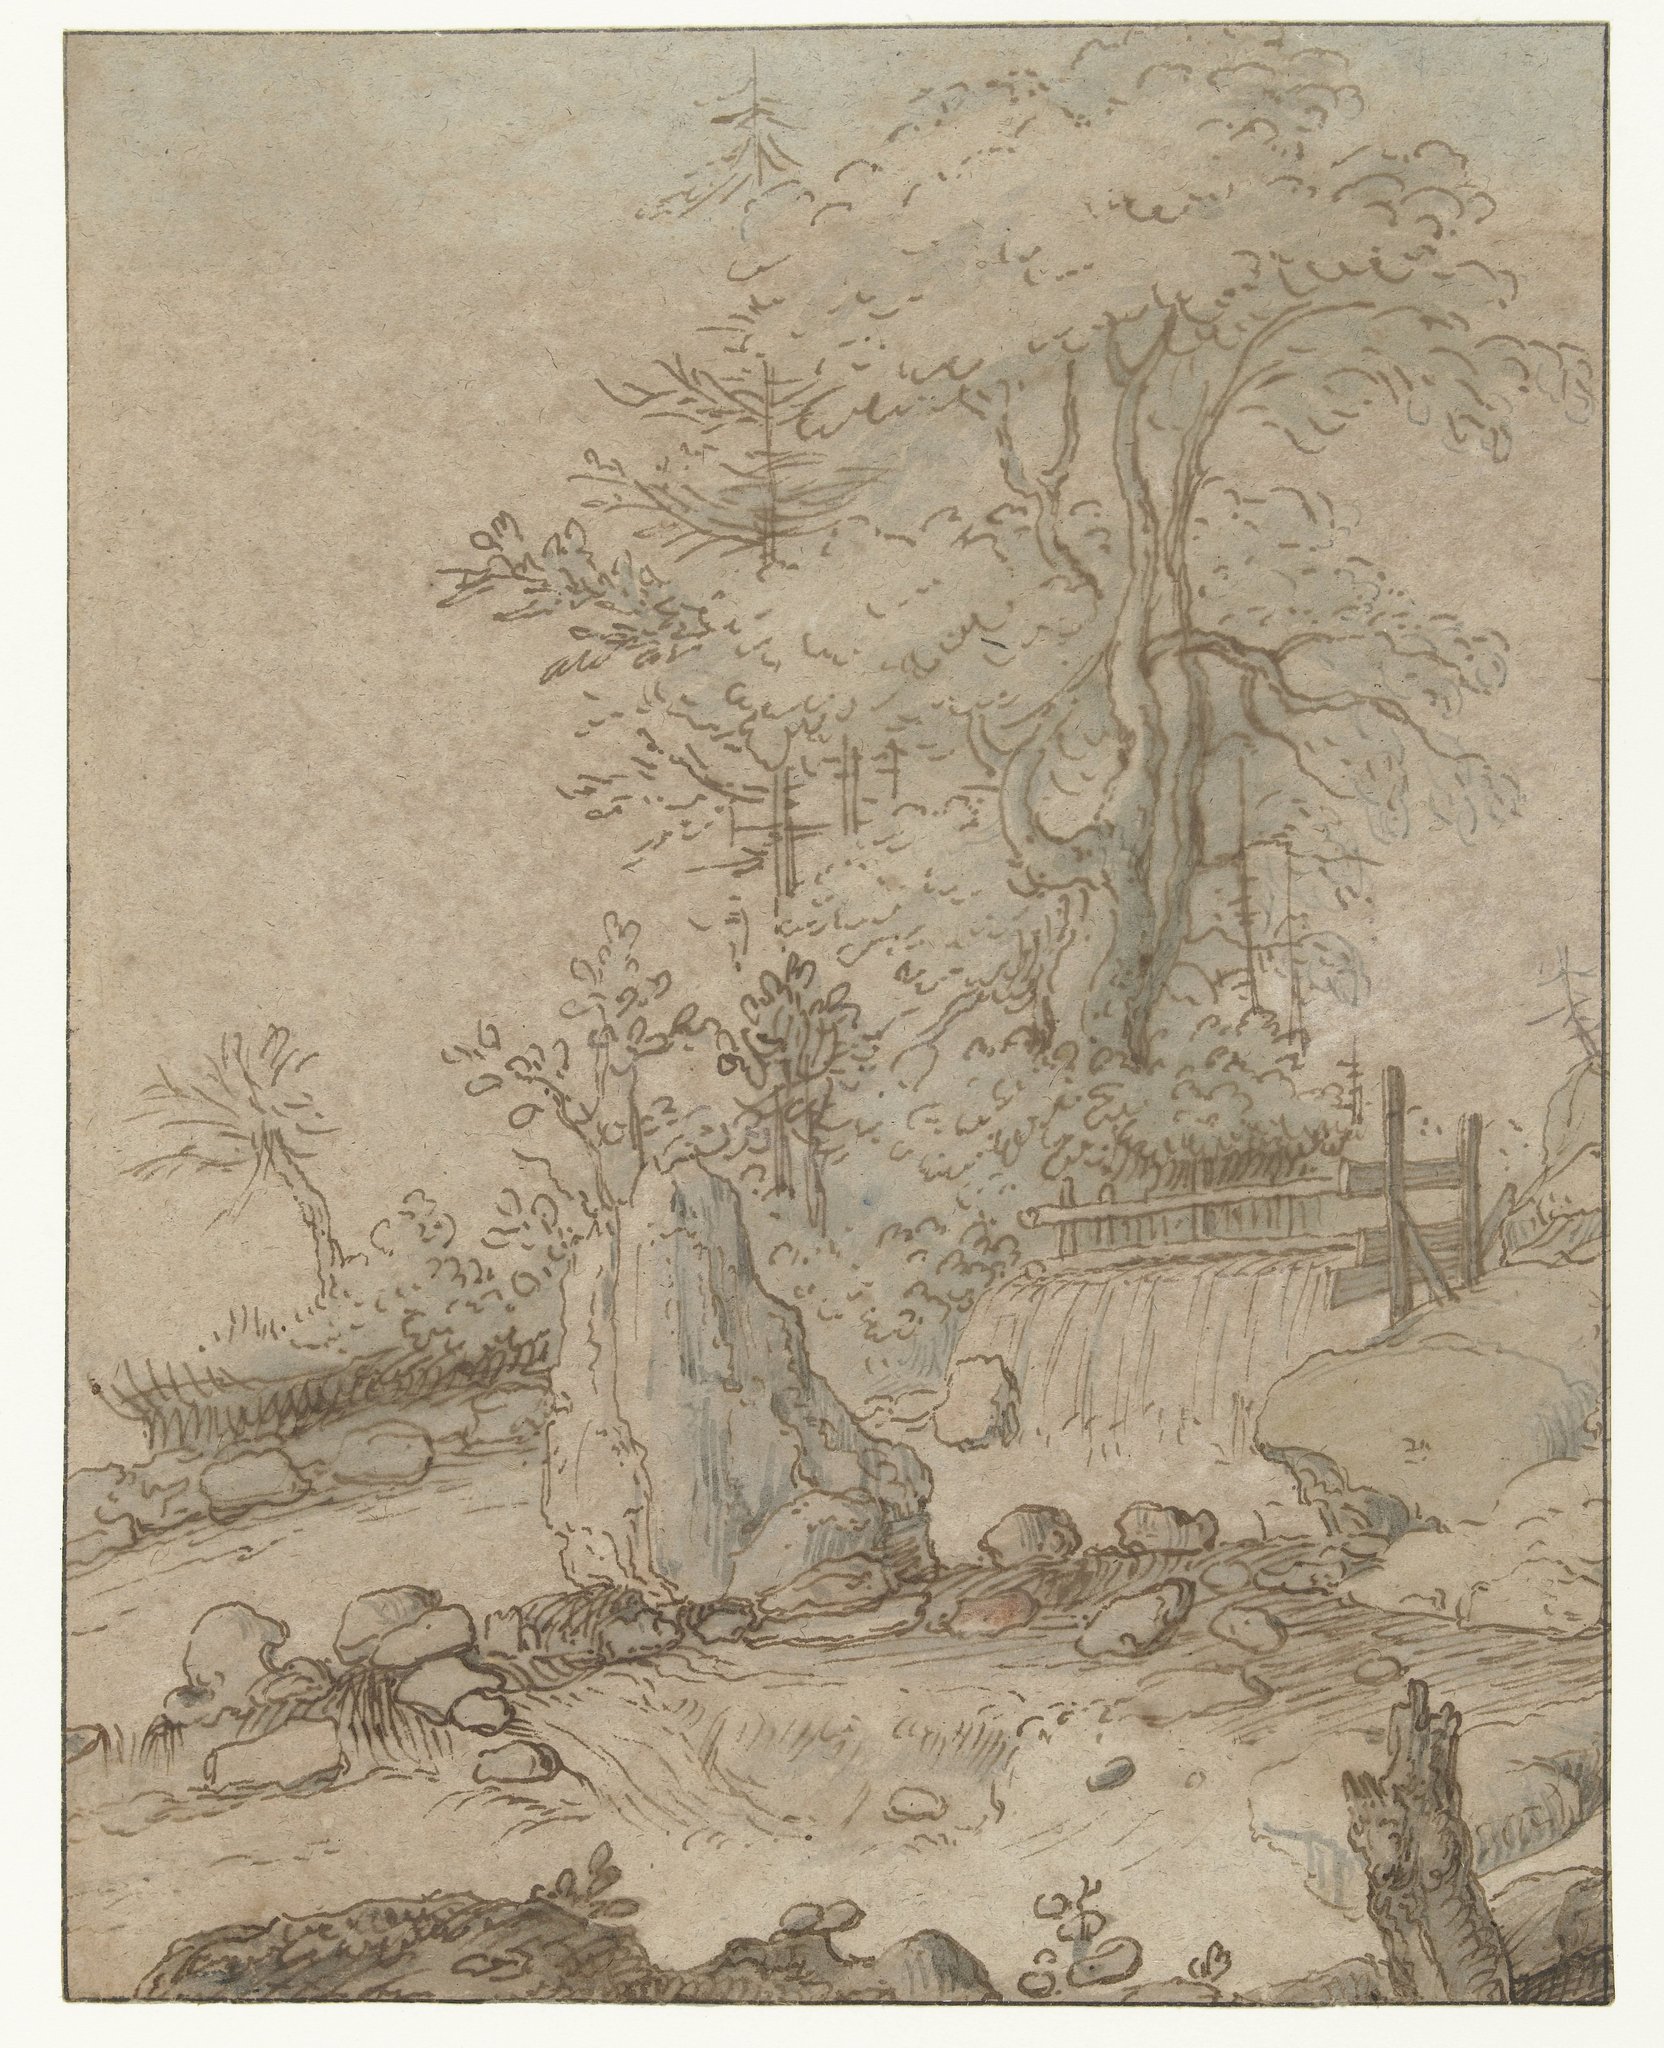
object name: drawing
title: Rotsachtig landschap met waterval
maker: Anonymous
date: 1600-1650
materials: ink, paint, paper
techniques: brush, pen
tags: waterfall